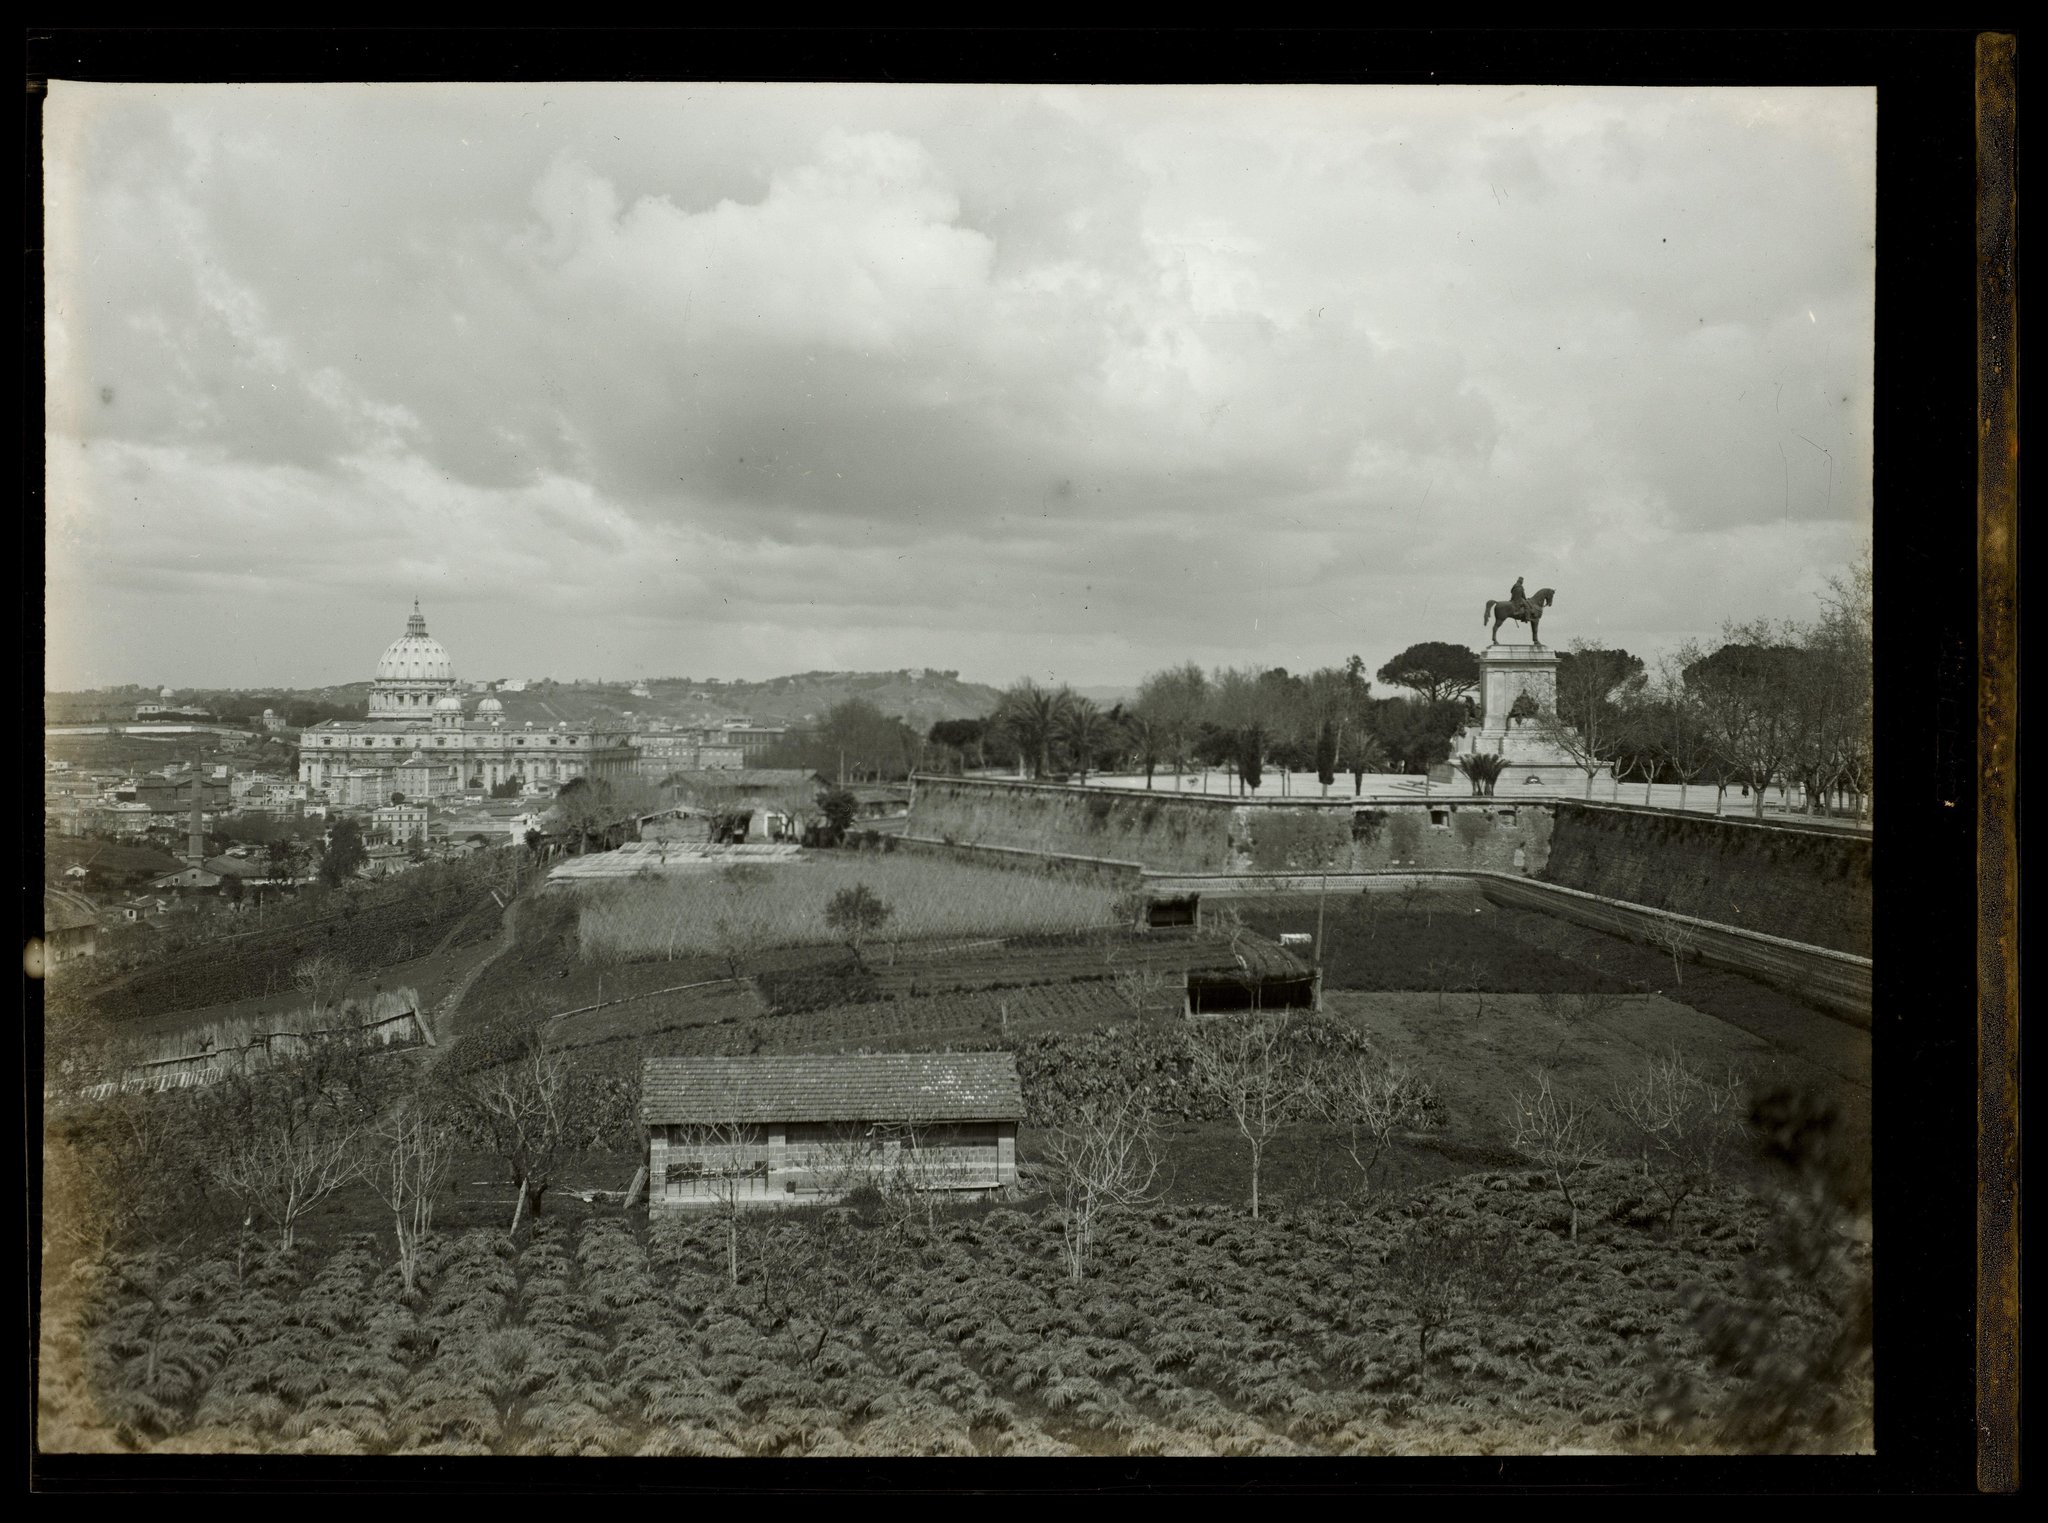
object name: photograph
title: Filmnegatief met opname van Rome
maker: Anonymous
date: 1907-1935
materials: film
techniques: gelatin silver negative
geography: rome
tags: rome